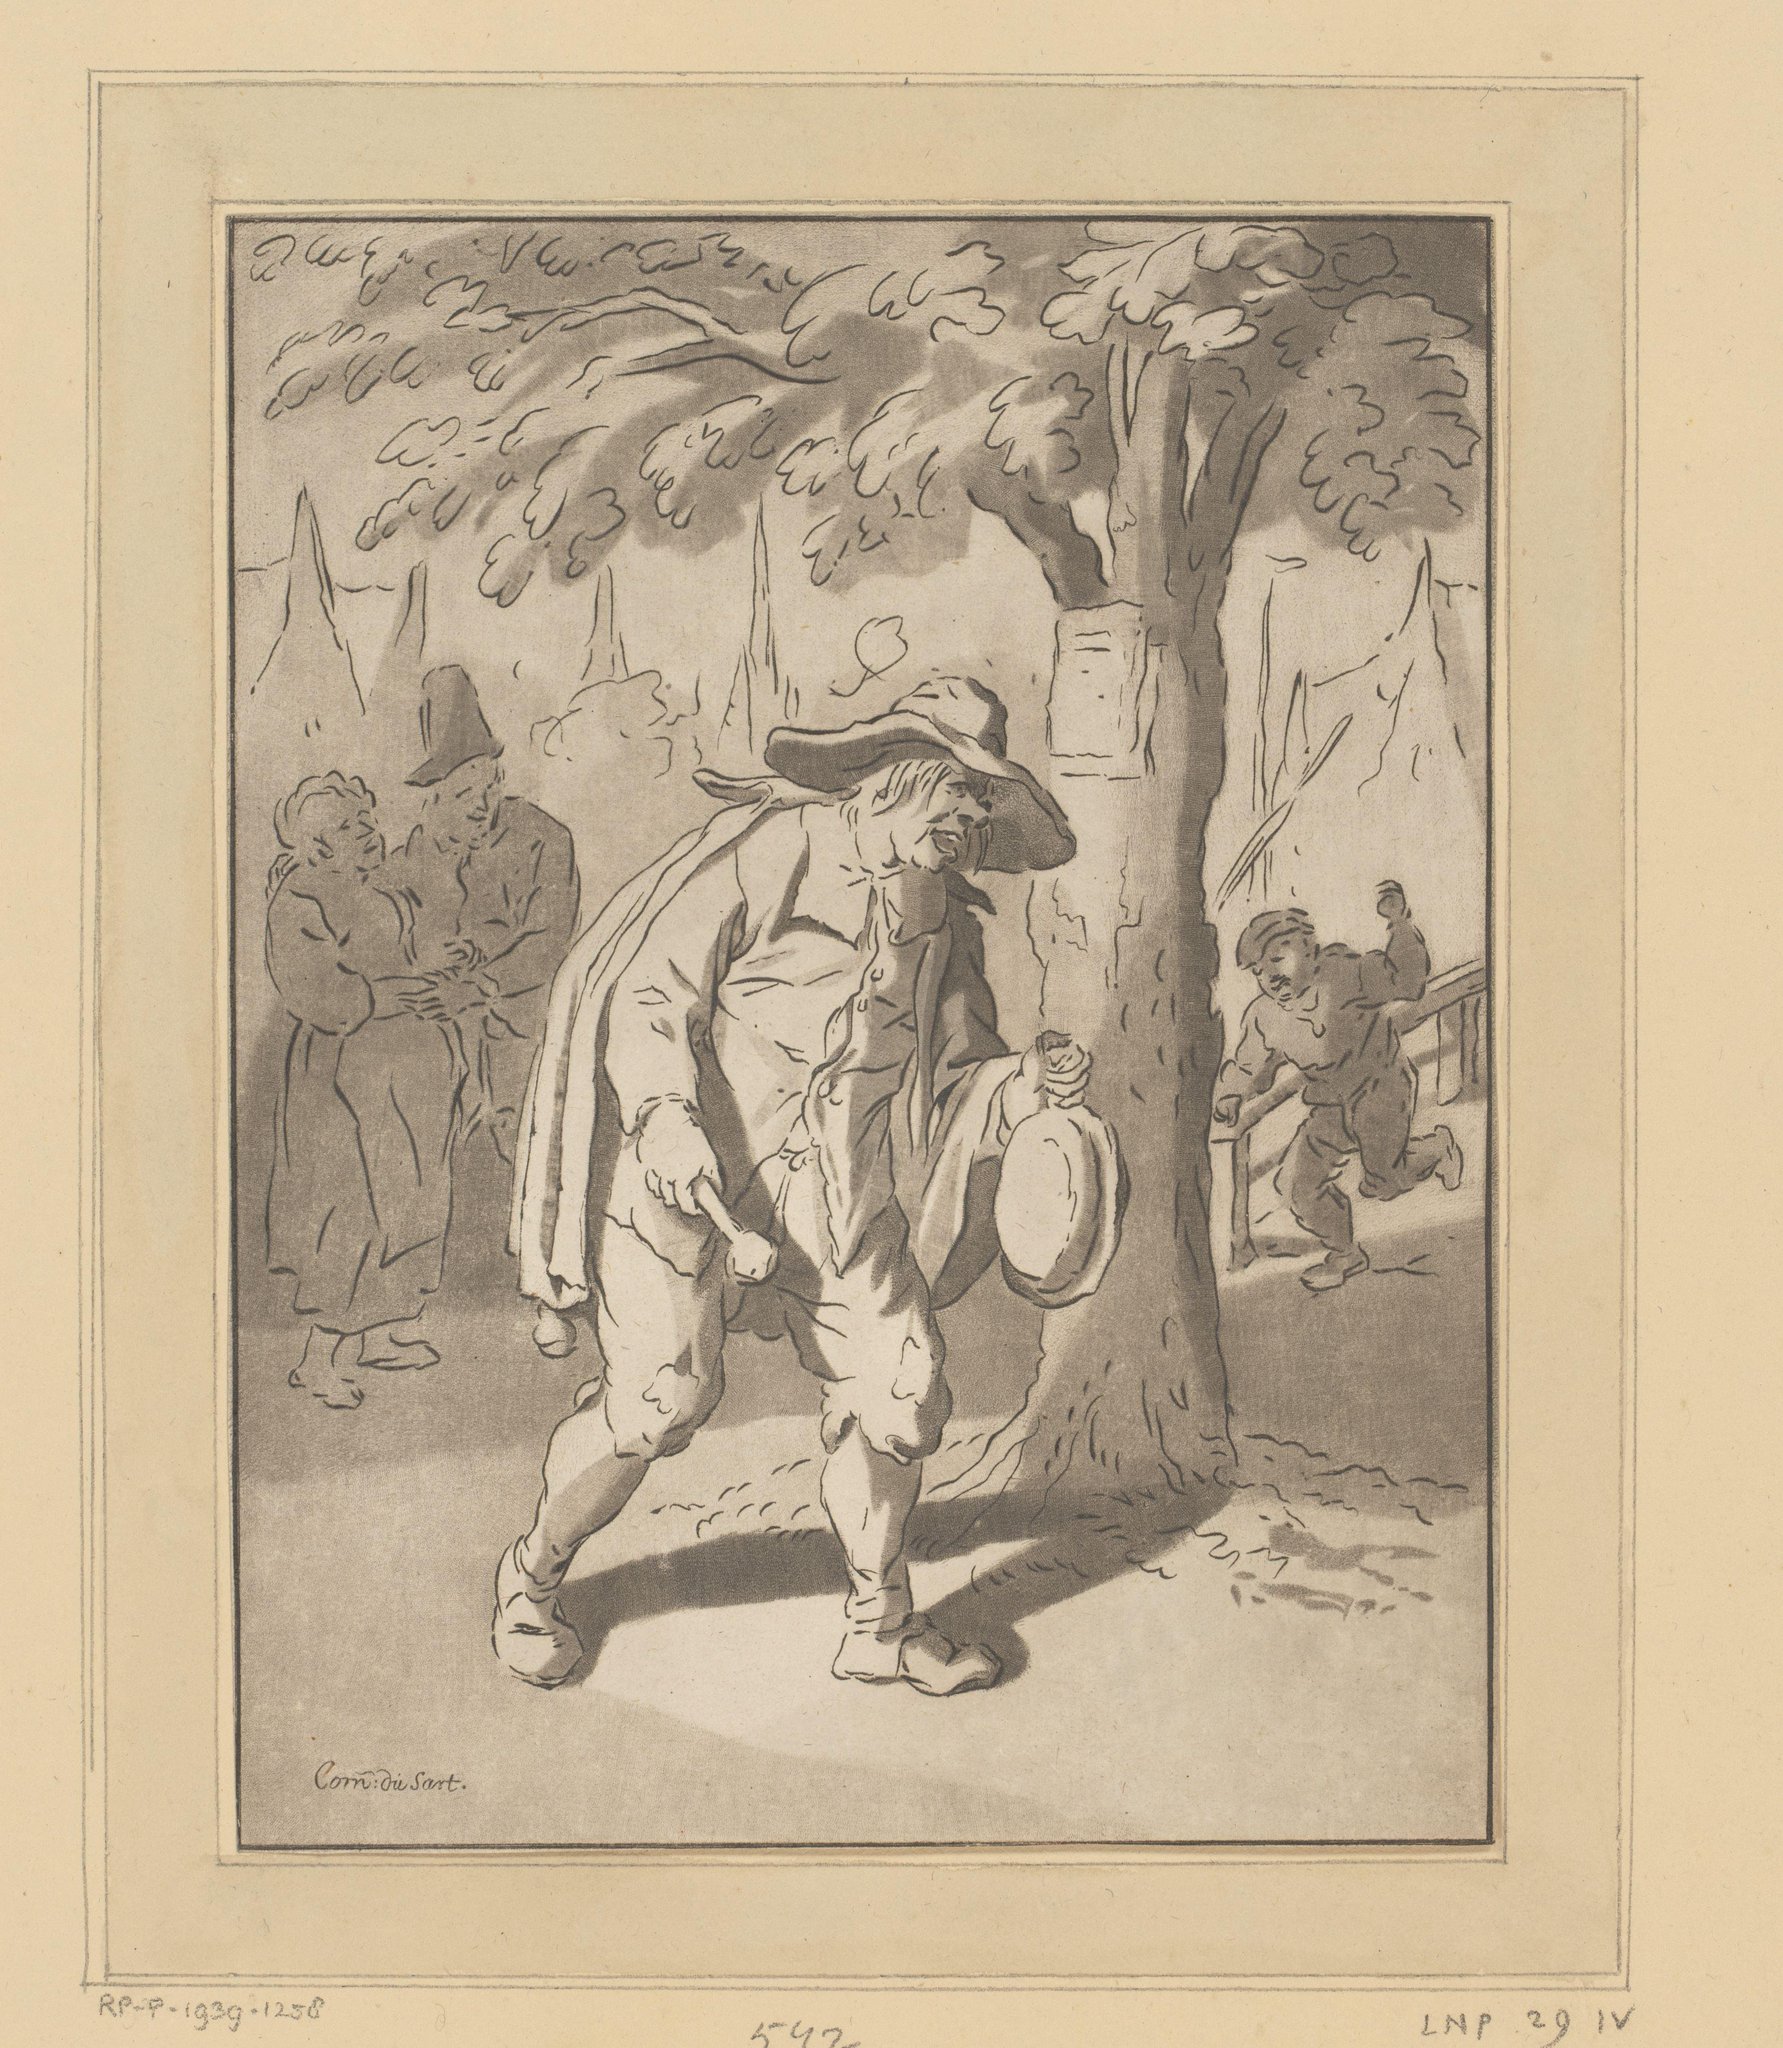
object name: print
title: Omroeper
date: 1776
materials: paper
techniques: etching, roulette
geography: amsterdam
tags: oral spreading of news, town crier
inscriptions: inscription: ‘Corn. Dusart. del. Ploos v. Amstel J.C. Fecit. 1776’, collector's mark: Lugt 2725, collector's mark: ‘RIJKS / MUSM’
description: Een stadsomroeper met slagwerk bij een boom. Op de achtergrond luisterende mensen. De prent ligt los in een album, zie blad 29.